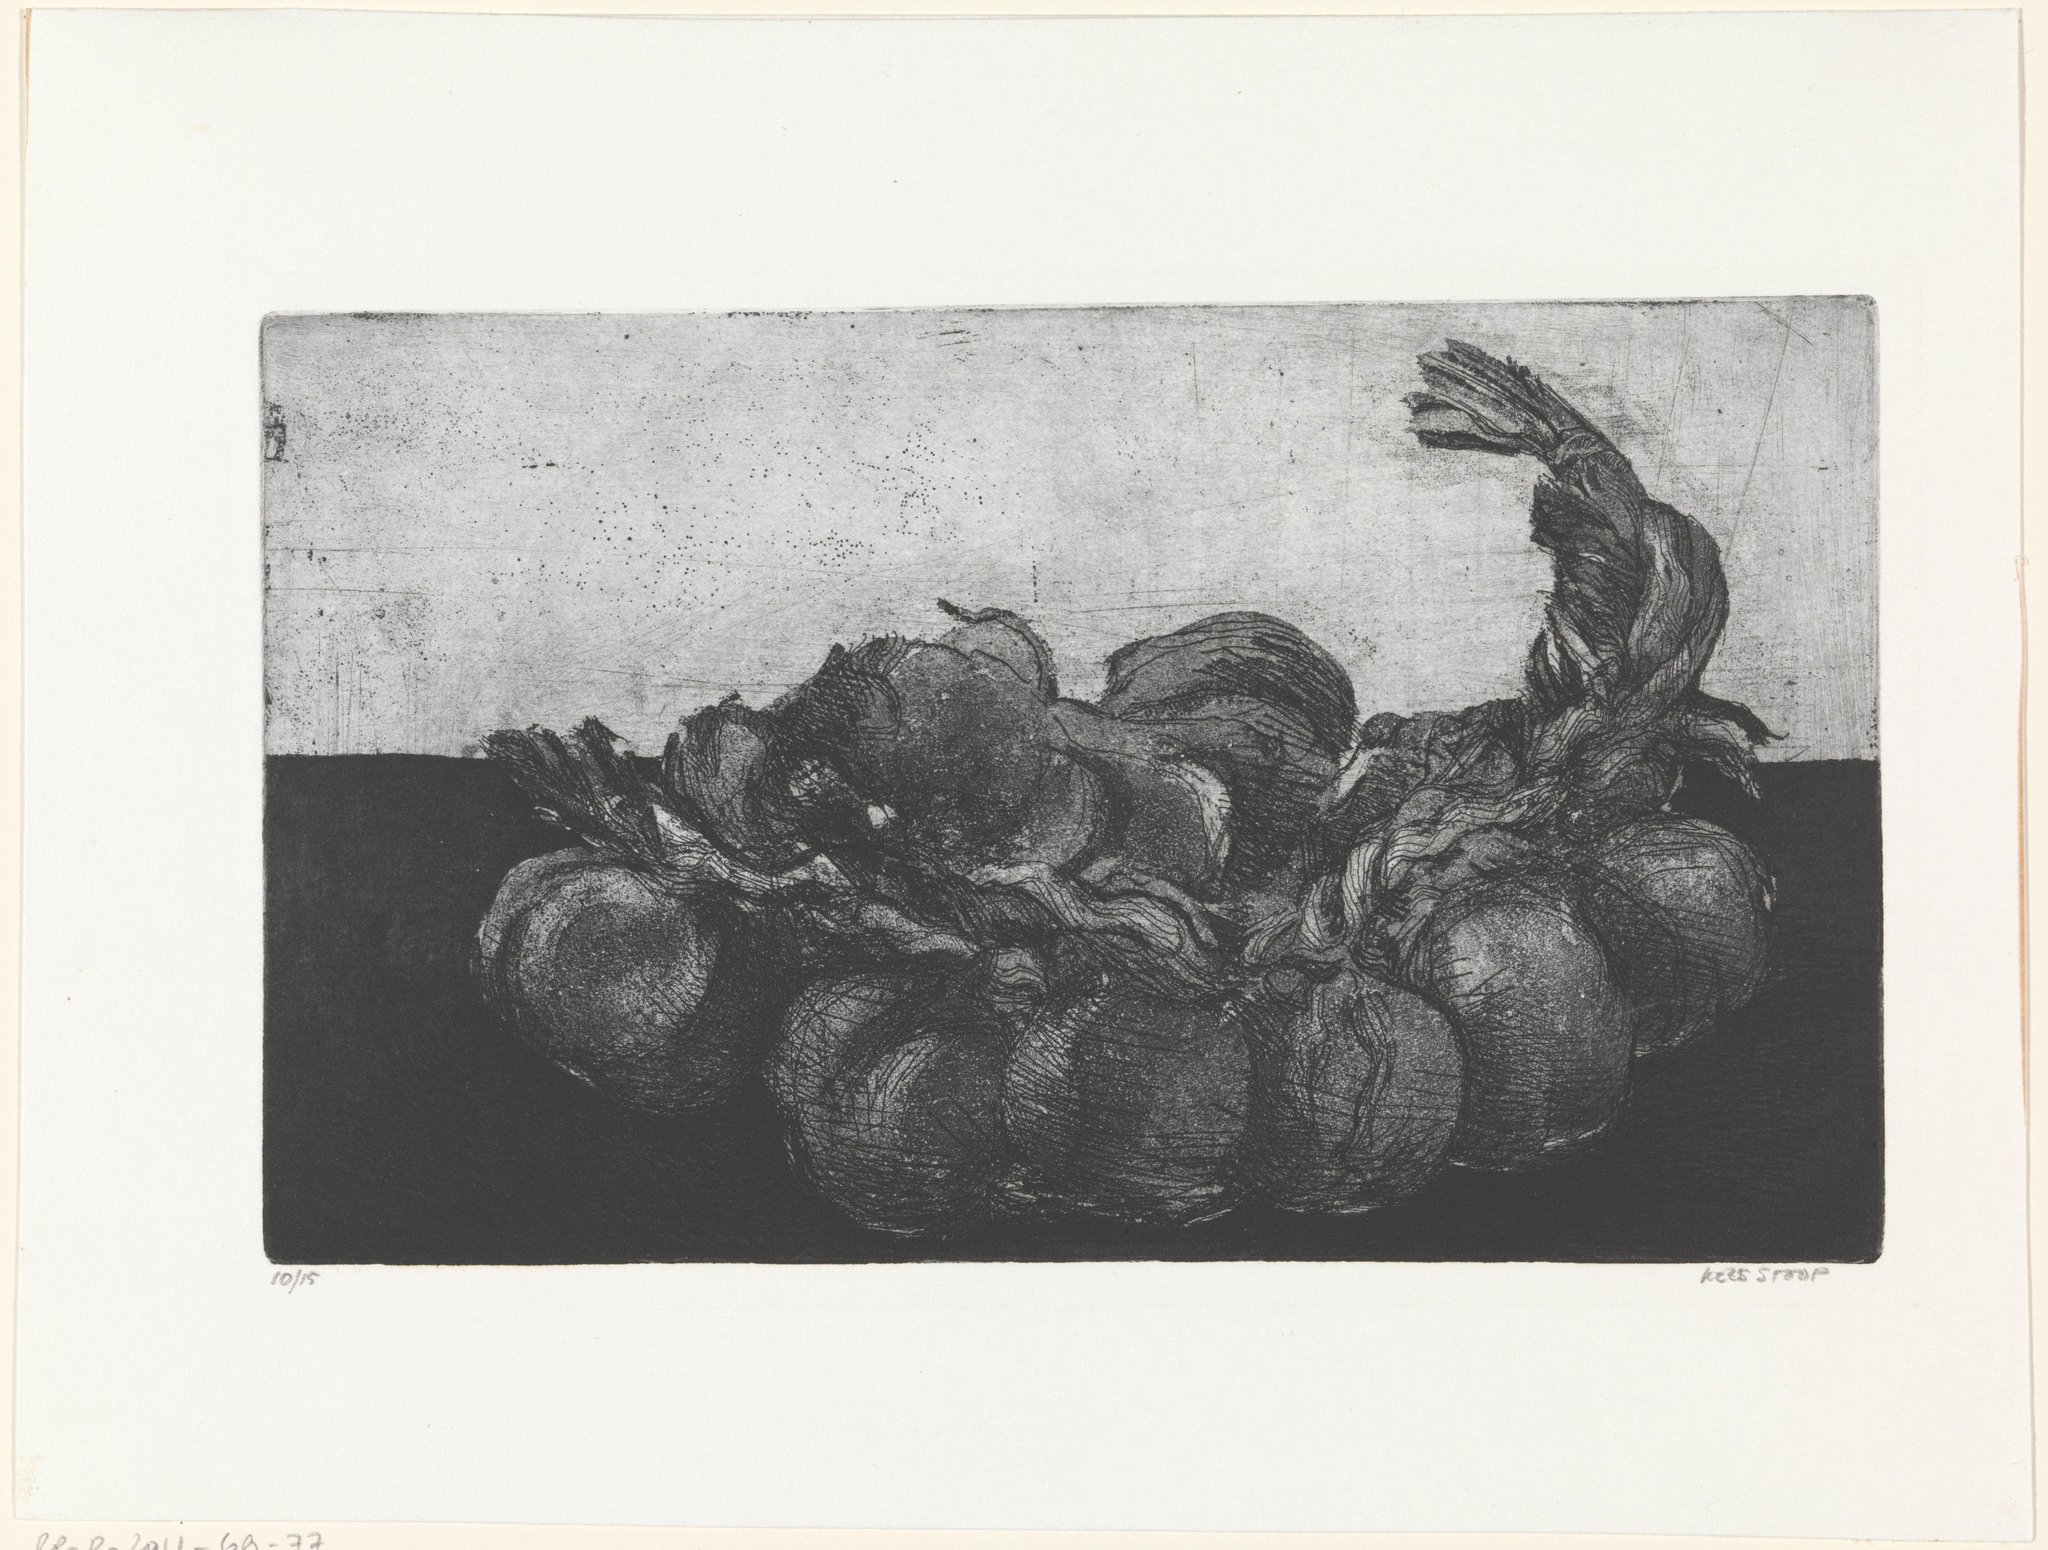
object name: print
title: Knooflookstreng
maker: kees stoop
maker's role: draughtsman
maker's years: 1929-2019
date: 1944-1990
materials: paper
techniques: aquatint, etching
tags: plants and herbs: garlic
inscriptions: signature: ‘KEES STOOP’, edition: ‘10/15’